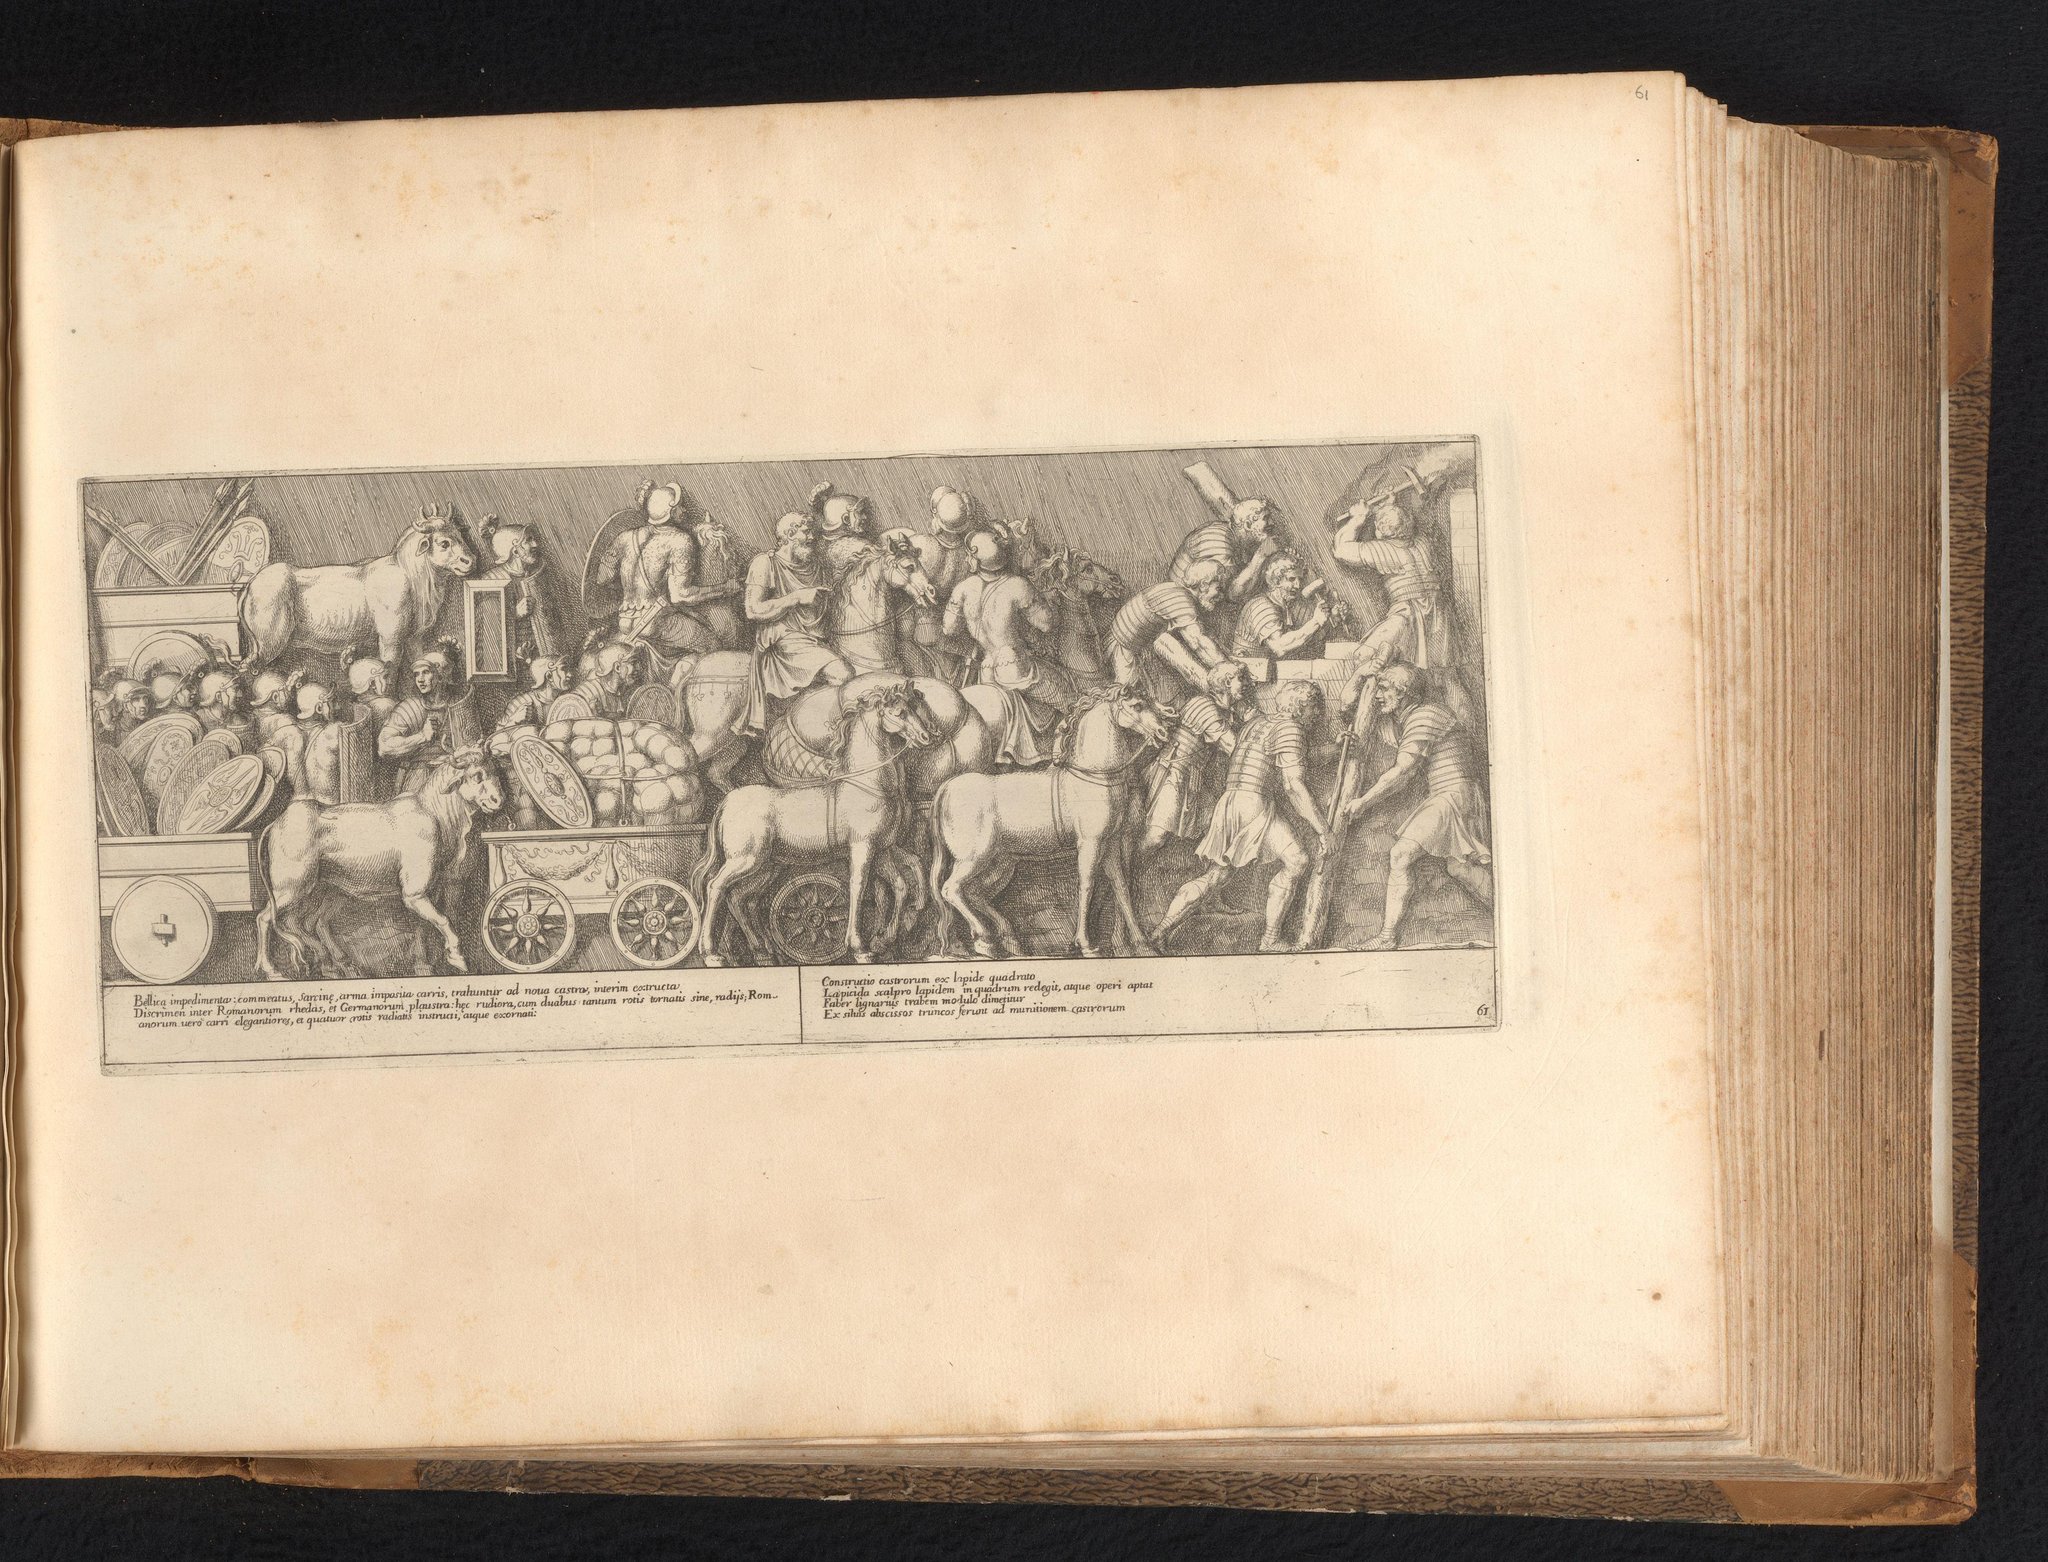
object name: album leaf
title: Columna Antoniniana Marci Aurelii Antonini Augusti rebus gestis insignis (...)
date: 1672-1675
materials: paper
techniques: etching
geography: rome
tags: triumphal column with helical friezes, piece of sculpture, reproduction of a piece of sculpture, the soldier; the soldier's life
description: Detail van het spiraalvormige gebeeldhouwde fries op de Zuil van Marcus Aurelius te Rome. Het fries toont de oorlog tussen het Romeinse leger van keizer Marcus Aurelius en de Germaanse stammen der Marcomannen en Quaden en de oorlog tegen de Sarmaten die vanuit het huidige Iran Hongarije waren binnengevallen. Tekst in de ondermarge. Prent maakt deel uit van een album.